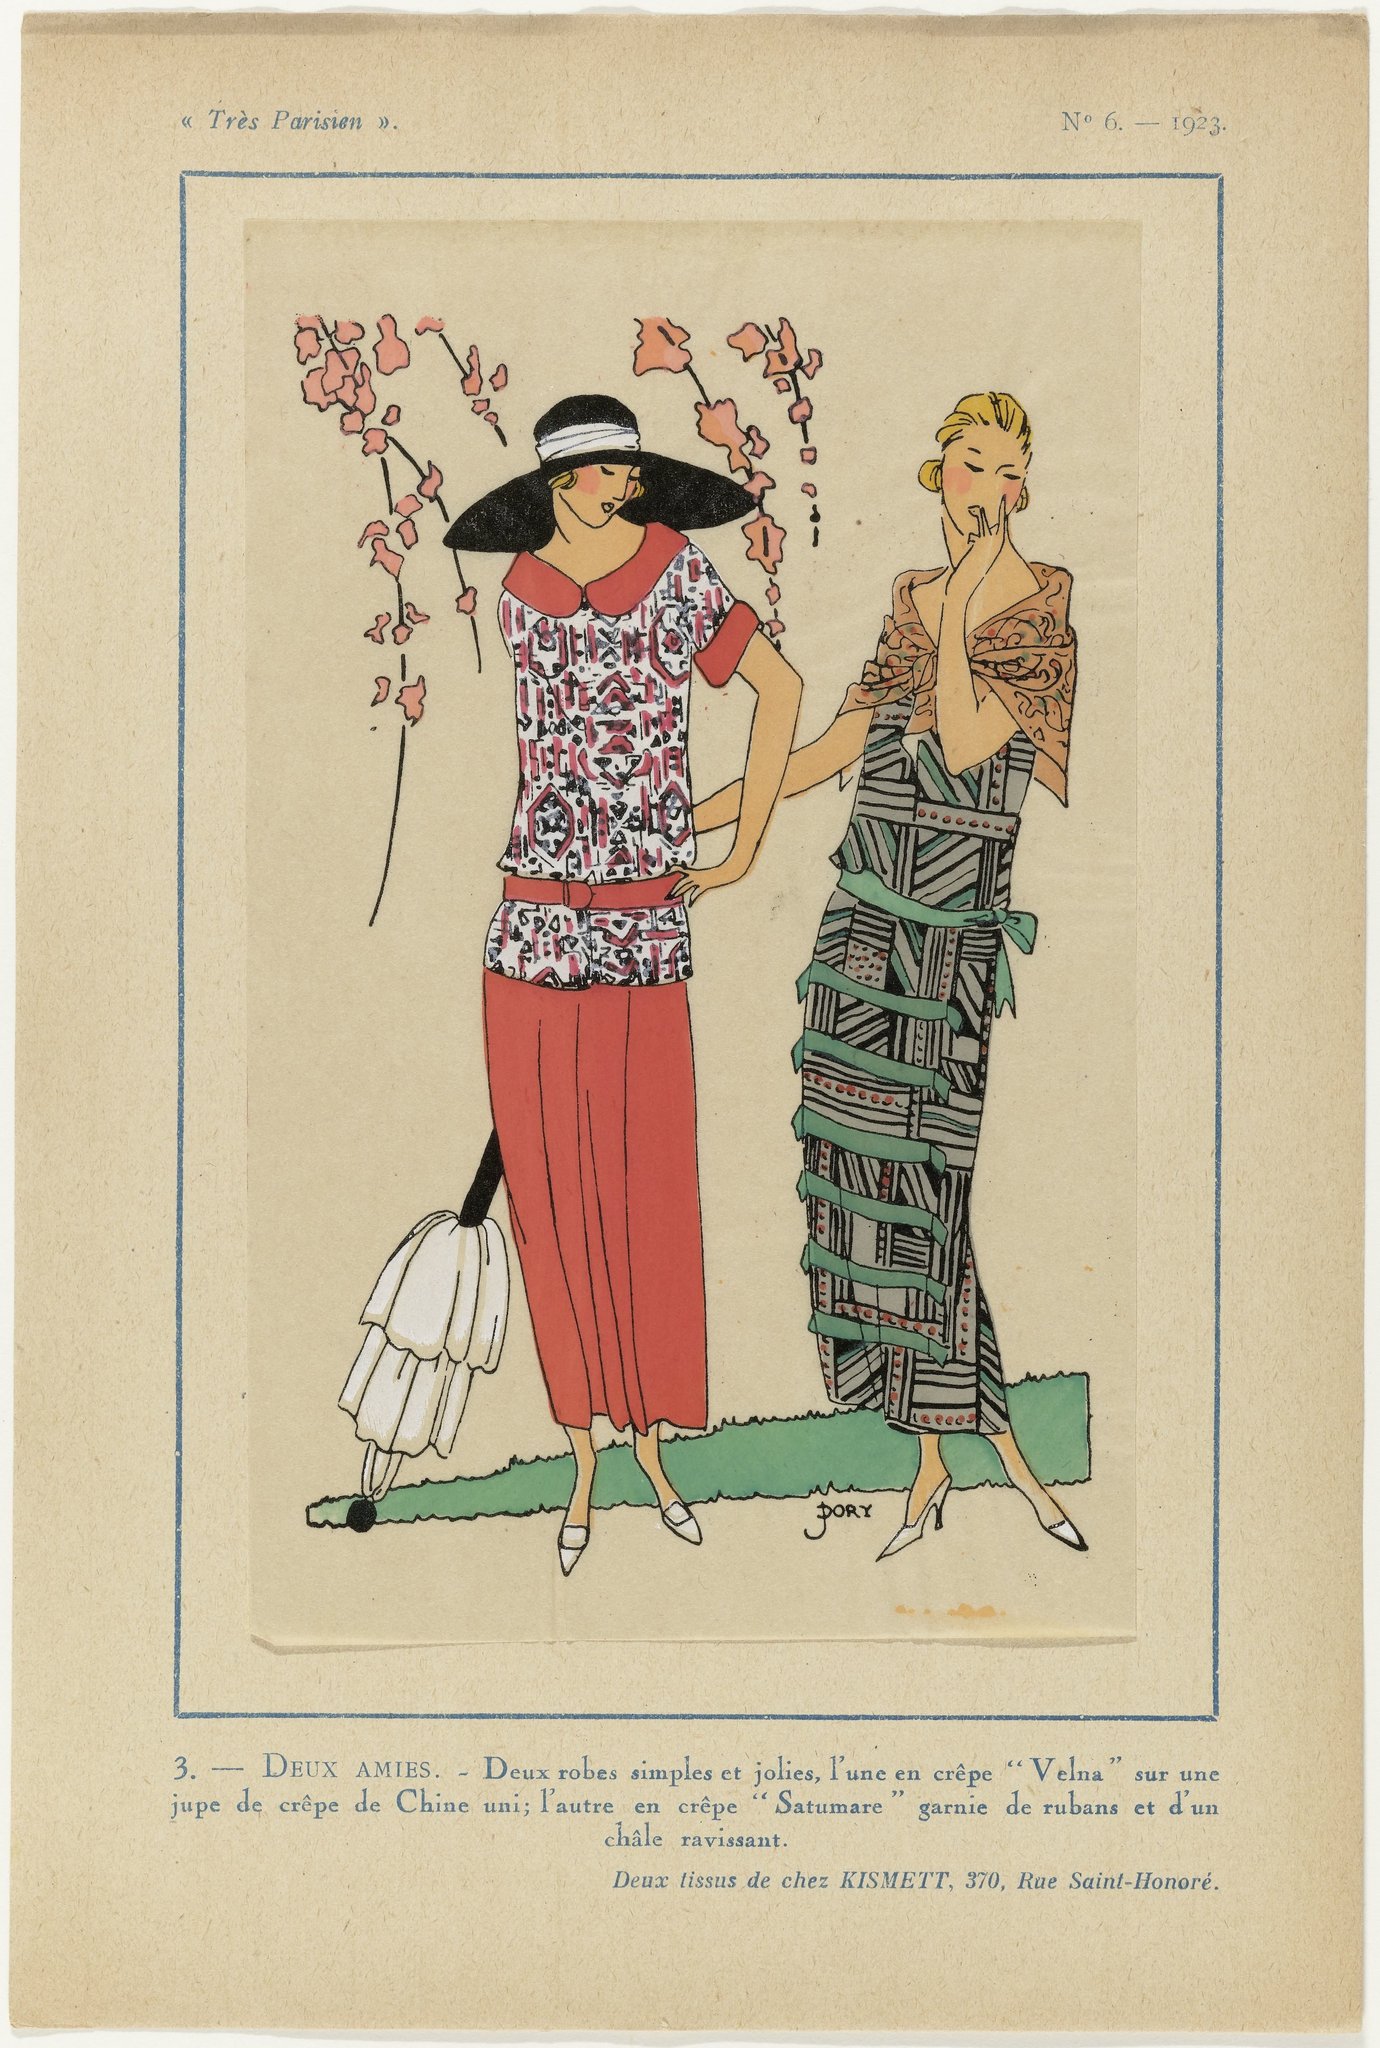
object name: fashion print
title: Très Parisien, 1923, No 6: 3.- DEUX AMIES. - Deux robes simples...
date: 1923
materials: paper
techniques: hand coloring, letterpress printing, lithography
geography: paris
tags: clothing for the upper part of the body (shawl) (+ women's clothes), border, ribbon, braid (+ women's clothes), fashion plates, head-gear: hat (+ women's clothes), dress, gown (+ women's clothes), parasol, sunshade (+ women's clothes)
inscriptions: caption: ‘3. - DEUX AMIES. - Deux robes simples et jolies, l'une en crêpe "Velna" sur une jupe de crêpe de Chine uni; l'autre en crêpe "Satumare" garnie de rubans et d'un châle ravissant. / Deux tissus de chez KISMETT, 370, Rue Saint-Honoré.’, title: ‘Très Parisien / No 6. - 1923’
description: Twee eenvoudige jurken: één van crêpe "Velna" op een effen rok van crêpe de Chine; de ander van crêpe "Satumare" gegarneerd met linten en een sjaal. Accessoires: hoed met brede rand, parasol(?), pumps.Twee stoffen van Kismett. Prent uit het modetijdschrift Très Parisien (1920-1936).